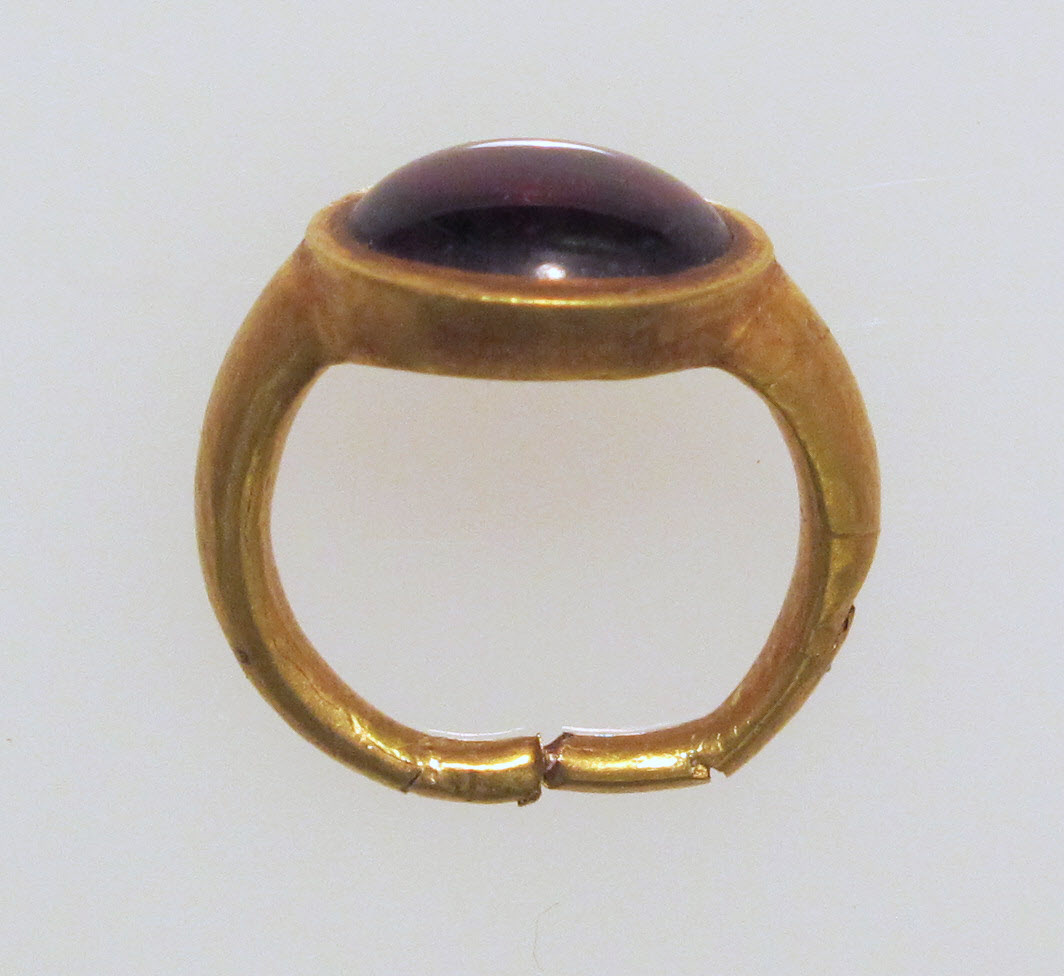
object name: ring with garnet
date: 7000 BCE-330 CE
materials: gemstone, gold